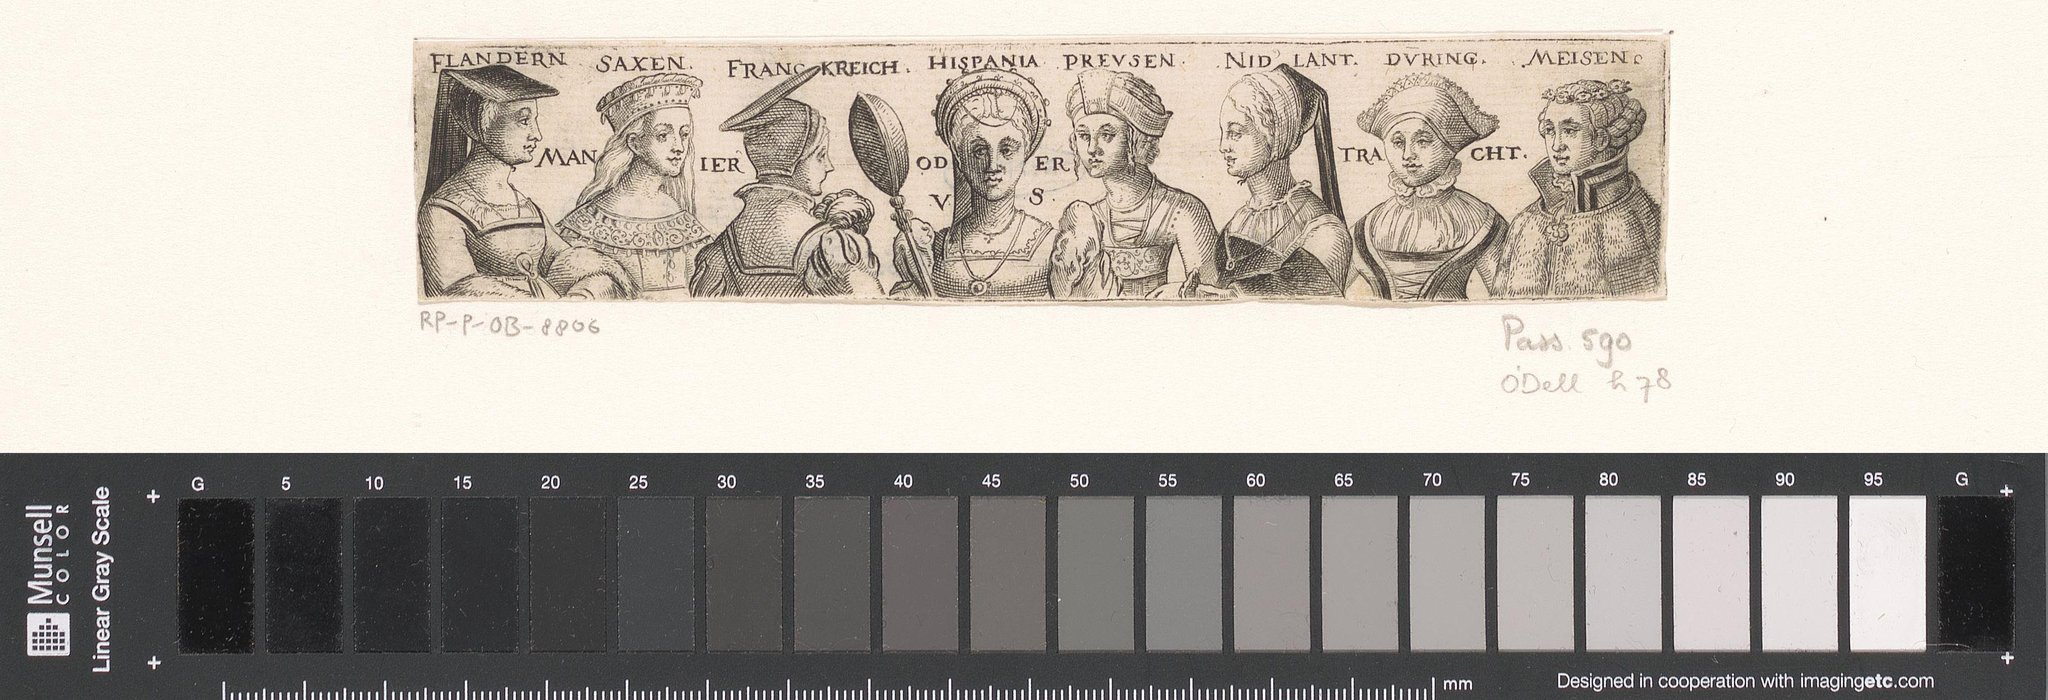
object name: print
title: Fries met acht busten van vrouwen van verschillende nationaliteiten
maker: virgilius solis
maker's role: draughtsman, print maker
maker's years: 1514-1562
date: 1524-1562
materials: paper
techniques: engraving, etching, intaglio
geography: nuremberg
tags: adult woman, head-gear, folk costume, regional costume, chest, bust - aa - female human figure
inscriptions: collector's mark: Lugt 2228, number: ‘10’